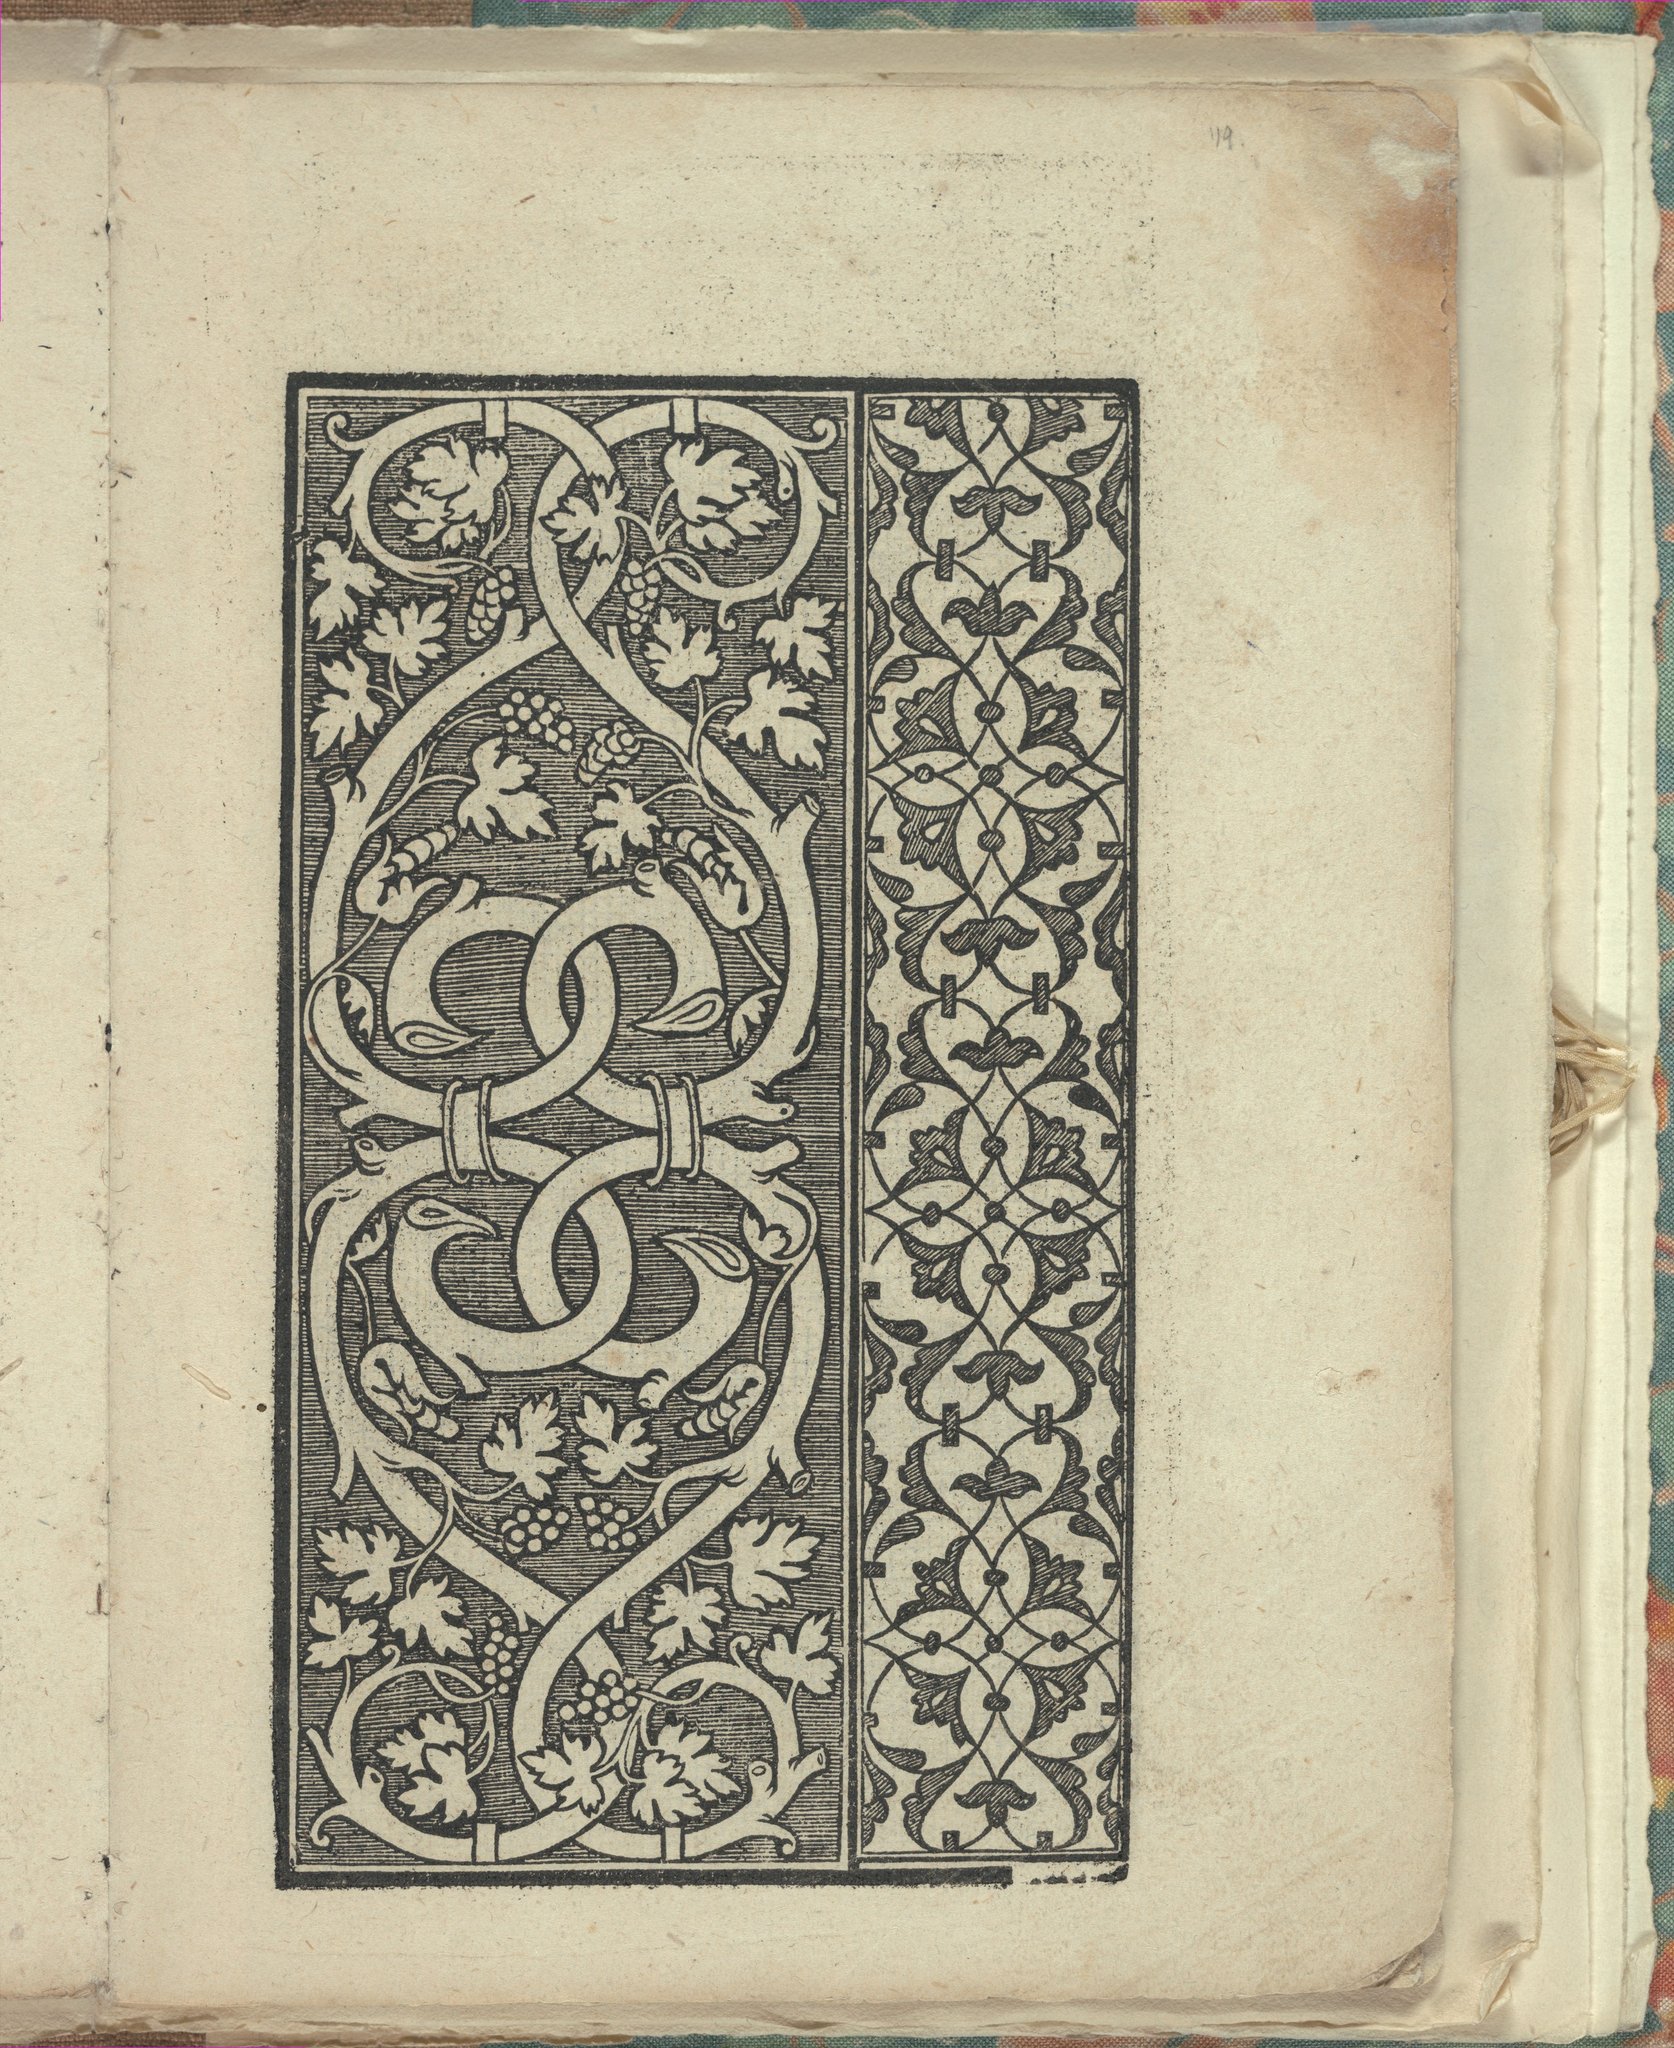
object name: book print ornament architecture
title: Opera Nova Universali intitulata Corona di racammi, page 19 (recto)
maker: giovanni andrea vavassore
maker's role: publisher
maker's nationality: italian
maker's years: 1530-1573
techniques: woodcut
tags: flowers